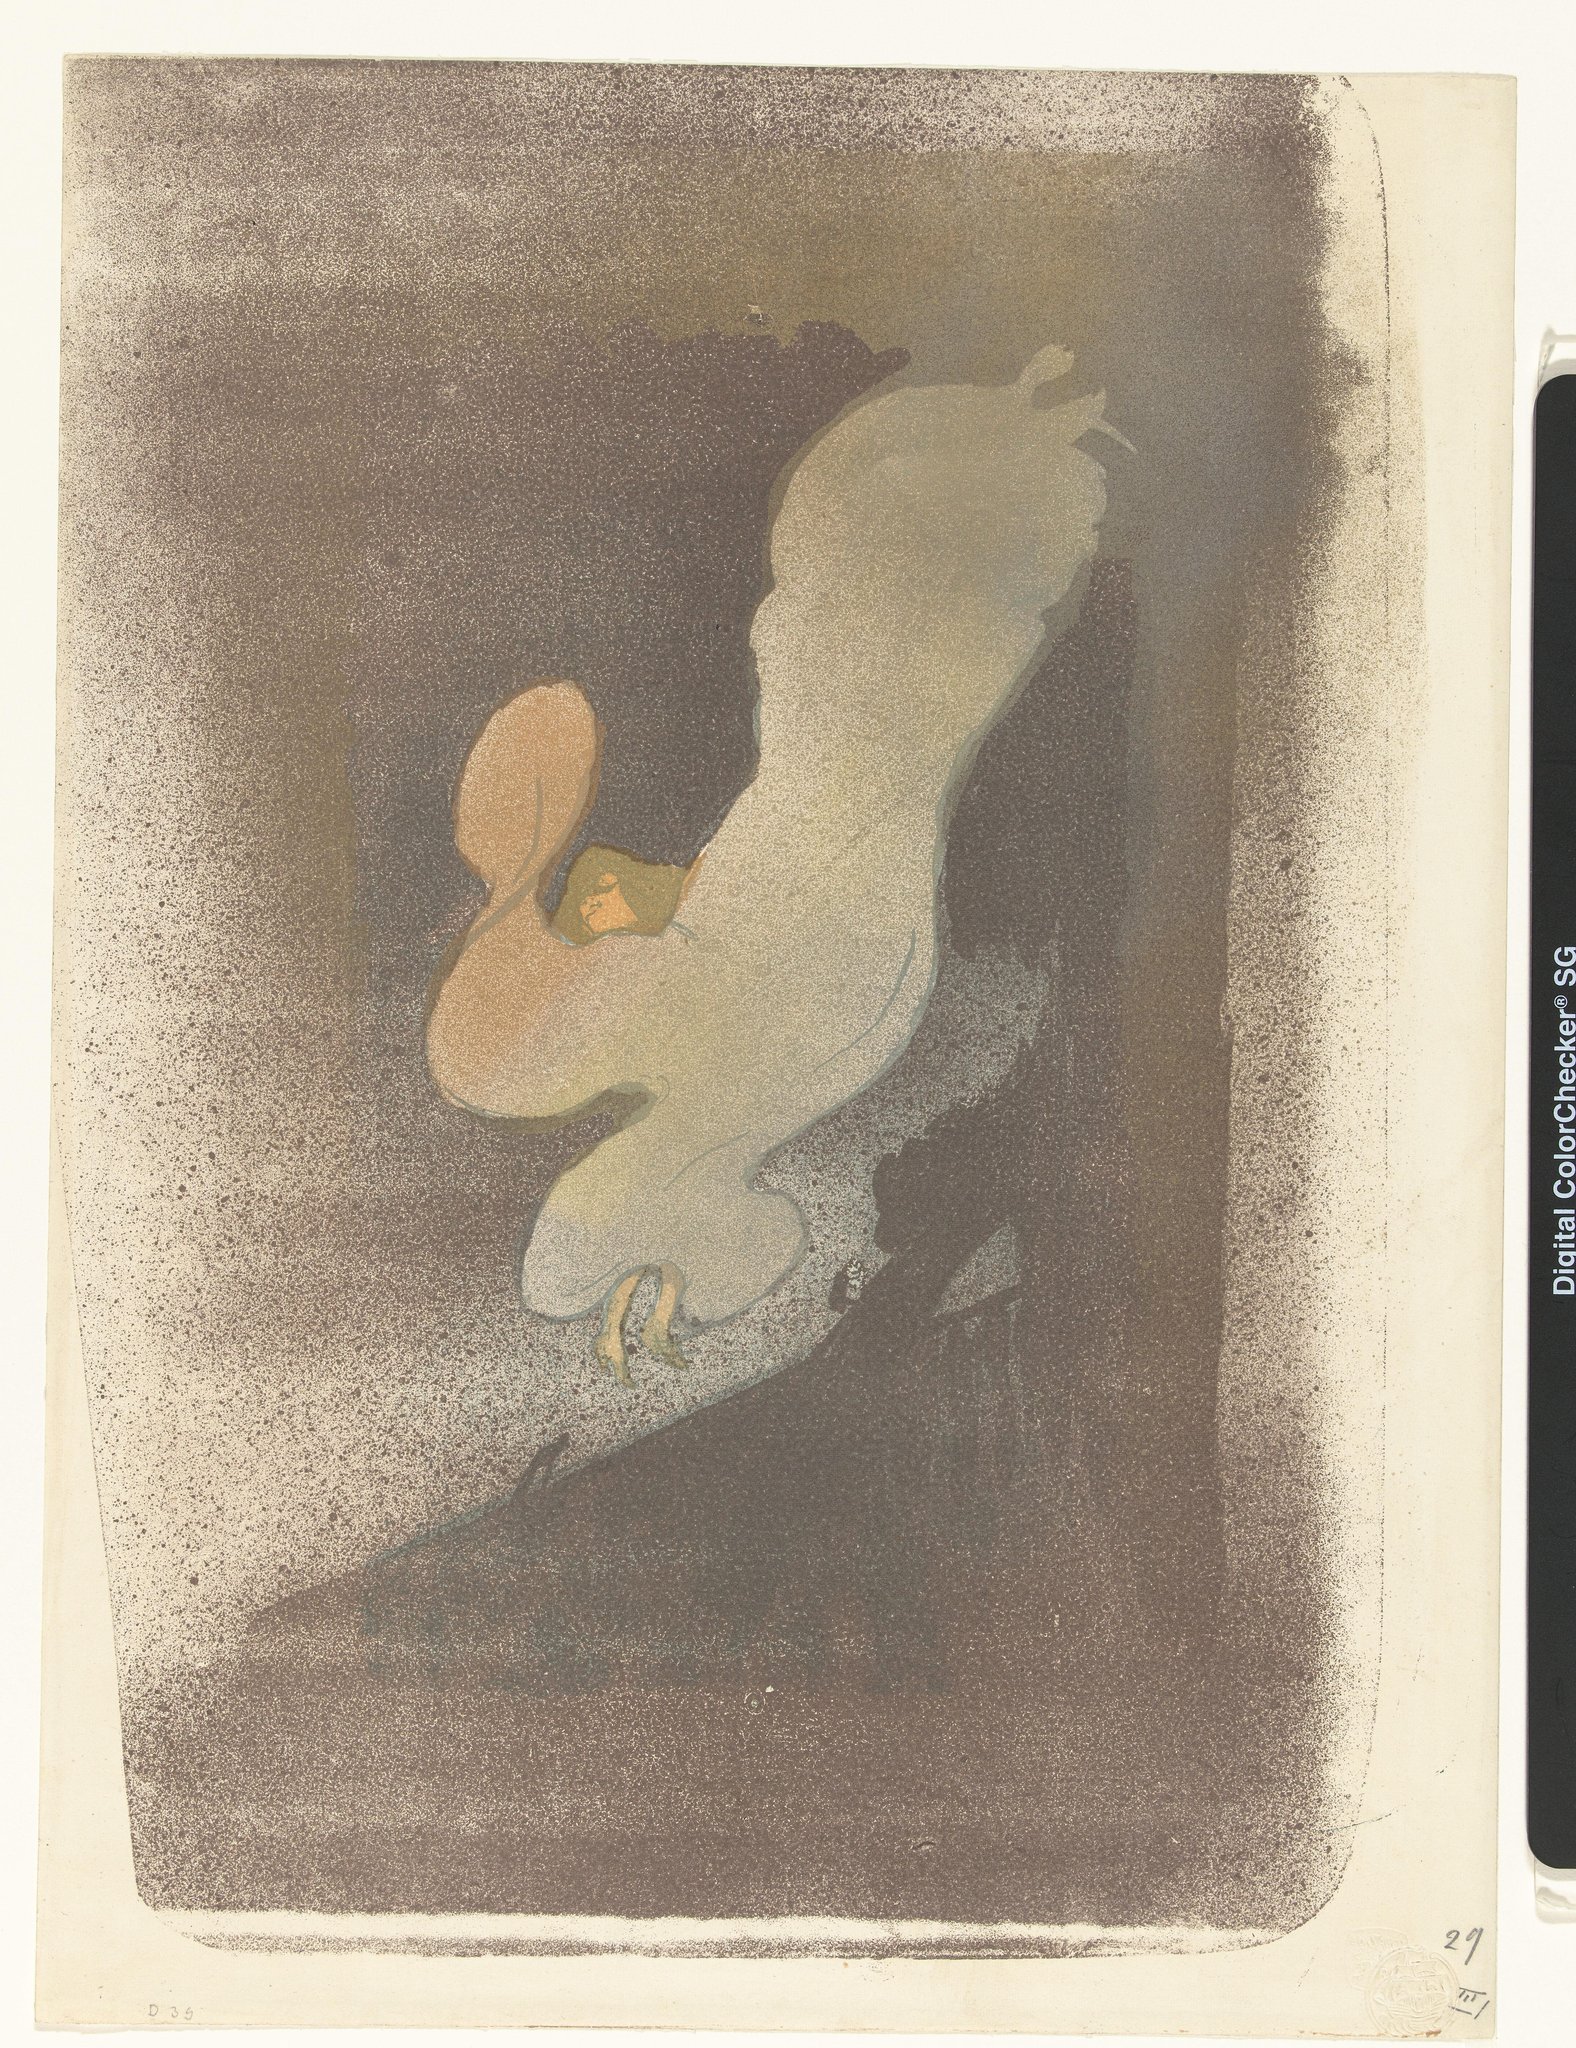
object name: print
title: Portret van danseres Loie Fuller tijdens een optreden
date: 1893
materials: paper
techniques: printing, lithograph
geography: paris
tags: female dancer, portrait of dancer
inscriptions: collector's mark: Lugt 2233, collector's mark: Lugt 2760, collector's mark: Lugt 2861b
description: Deze lithografie verscheen in een oplage van circa zestig exemplaren die allemaal uniek zijn. Elke prent is samengesteld met stenen in verschillende kleuren. Men veronderstelt dat Toulouse-Lautrec zelf nauw betrokken was bij het drukproces. Door de toevoeging van goud- en zilverpoeder en het wegvegen van een restant aan poeder op de nog natte druk, ontstaat het effect van een aquarel (Wittrock 1985, p. 88).